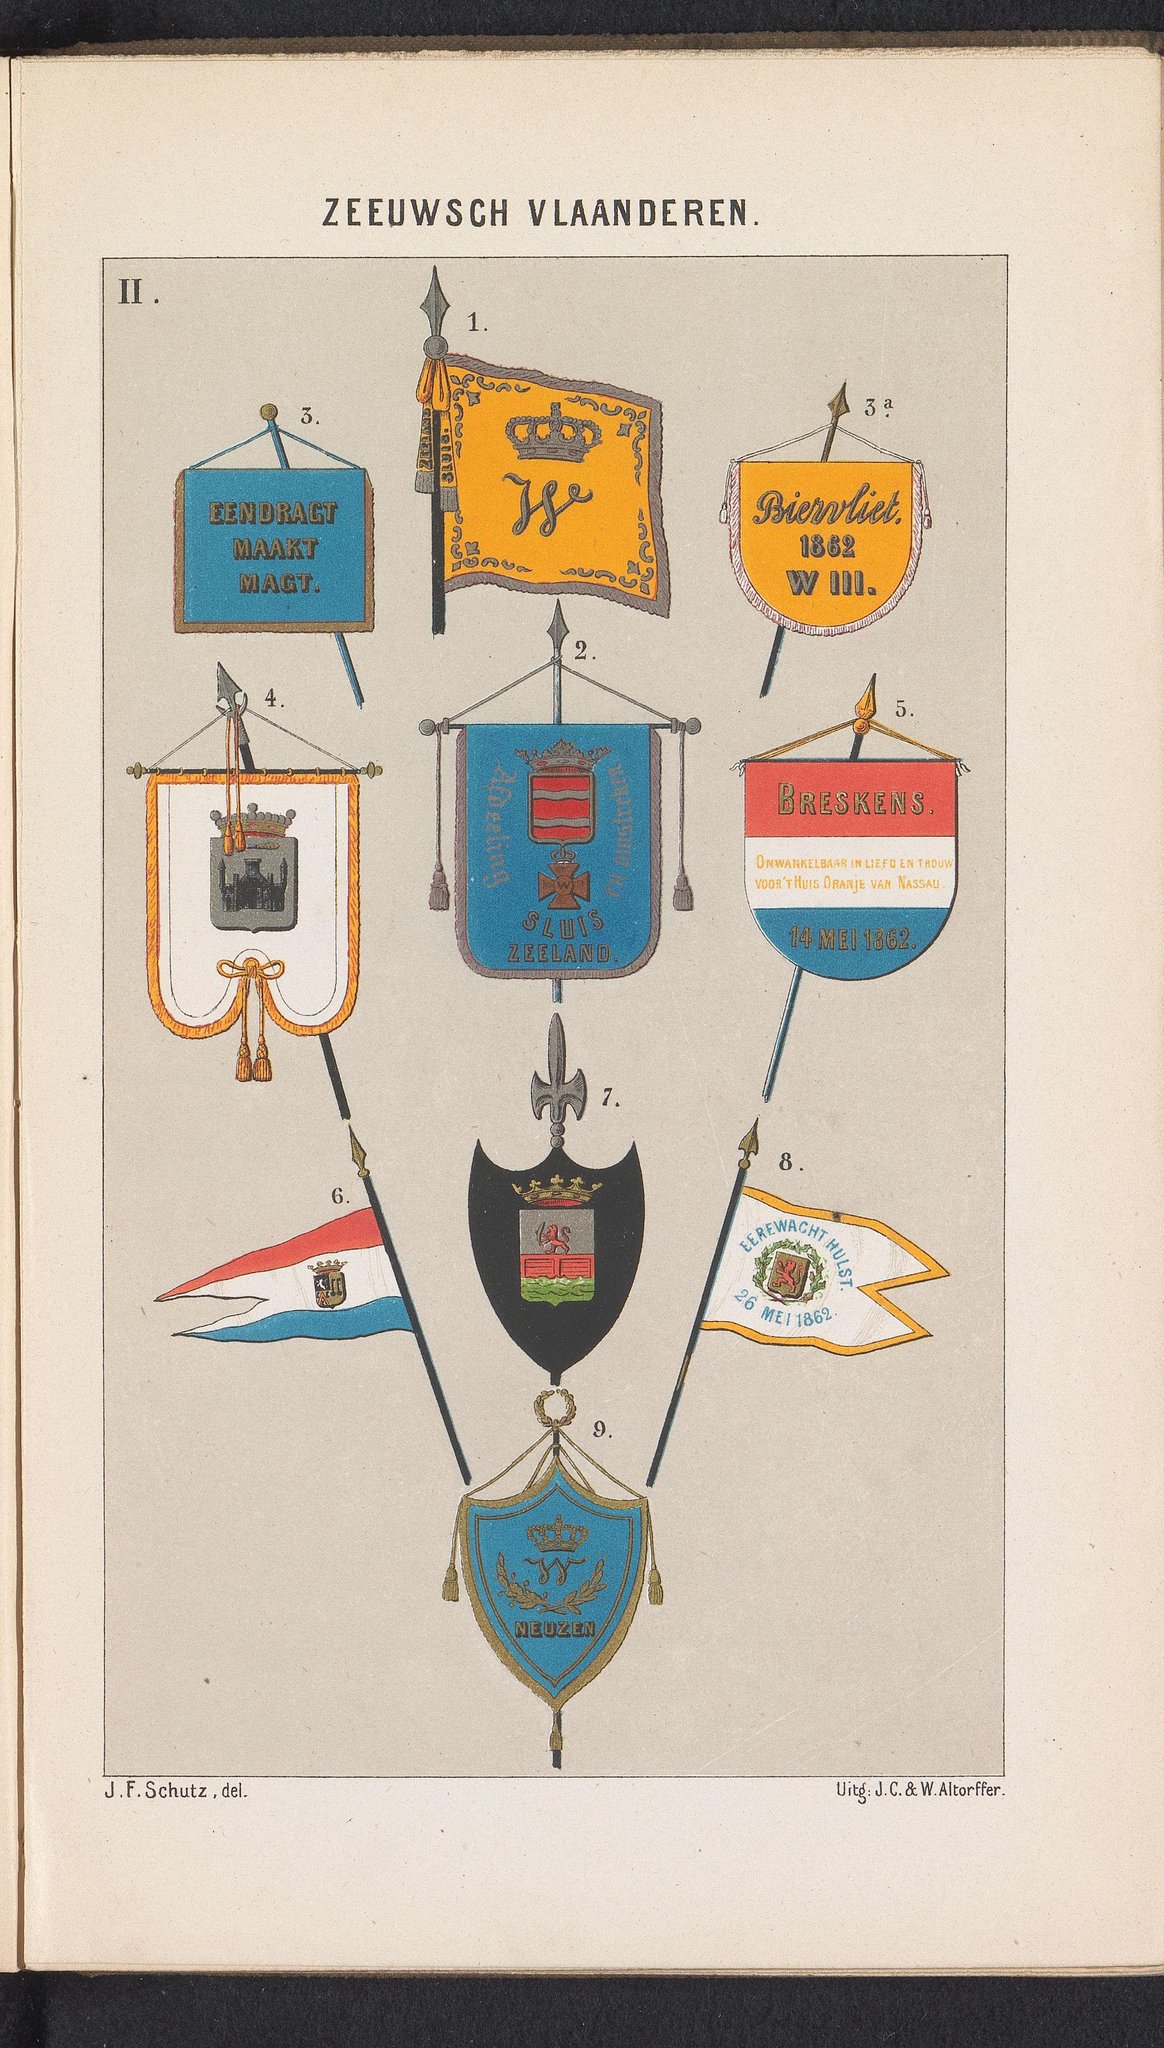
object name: print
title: Zeeuwsch Vlaanderen / II.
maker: jan frederik schütz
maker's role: draughtsman, painter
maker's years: 1817-1888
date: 1843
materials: paper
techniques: chromolithography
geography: middelburg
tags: brussels, willem iii (koning der nederlanden), banner, standard (as symbol of the state, etc.), (military) flags and standards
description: Negen banieren van de erewachten op Zeeuws-Vlaanderen tijdens het bezoek van koning Willem III aan Zeeland op 21-30 mei 1862. Illustratie in het boek 'Willem III in Zeeland'.